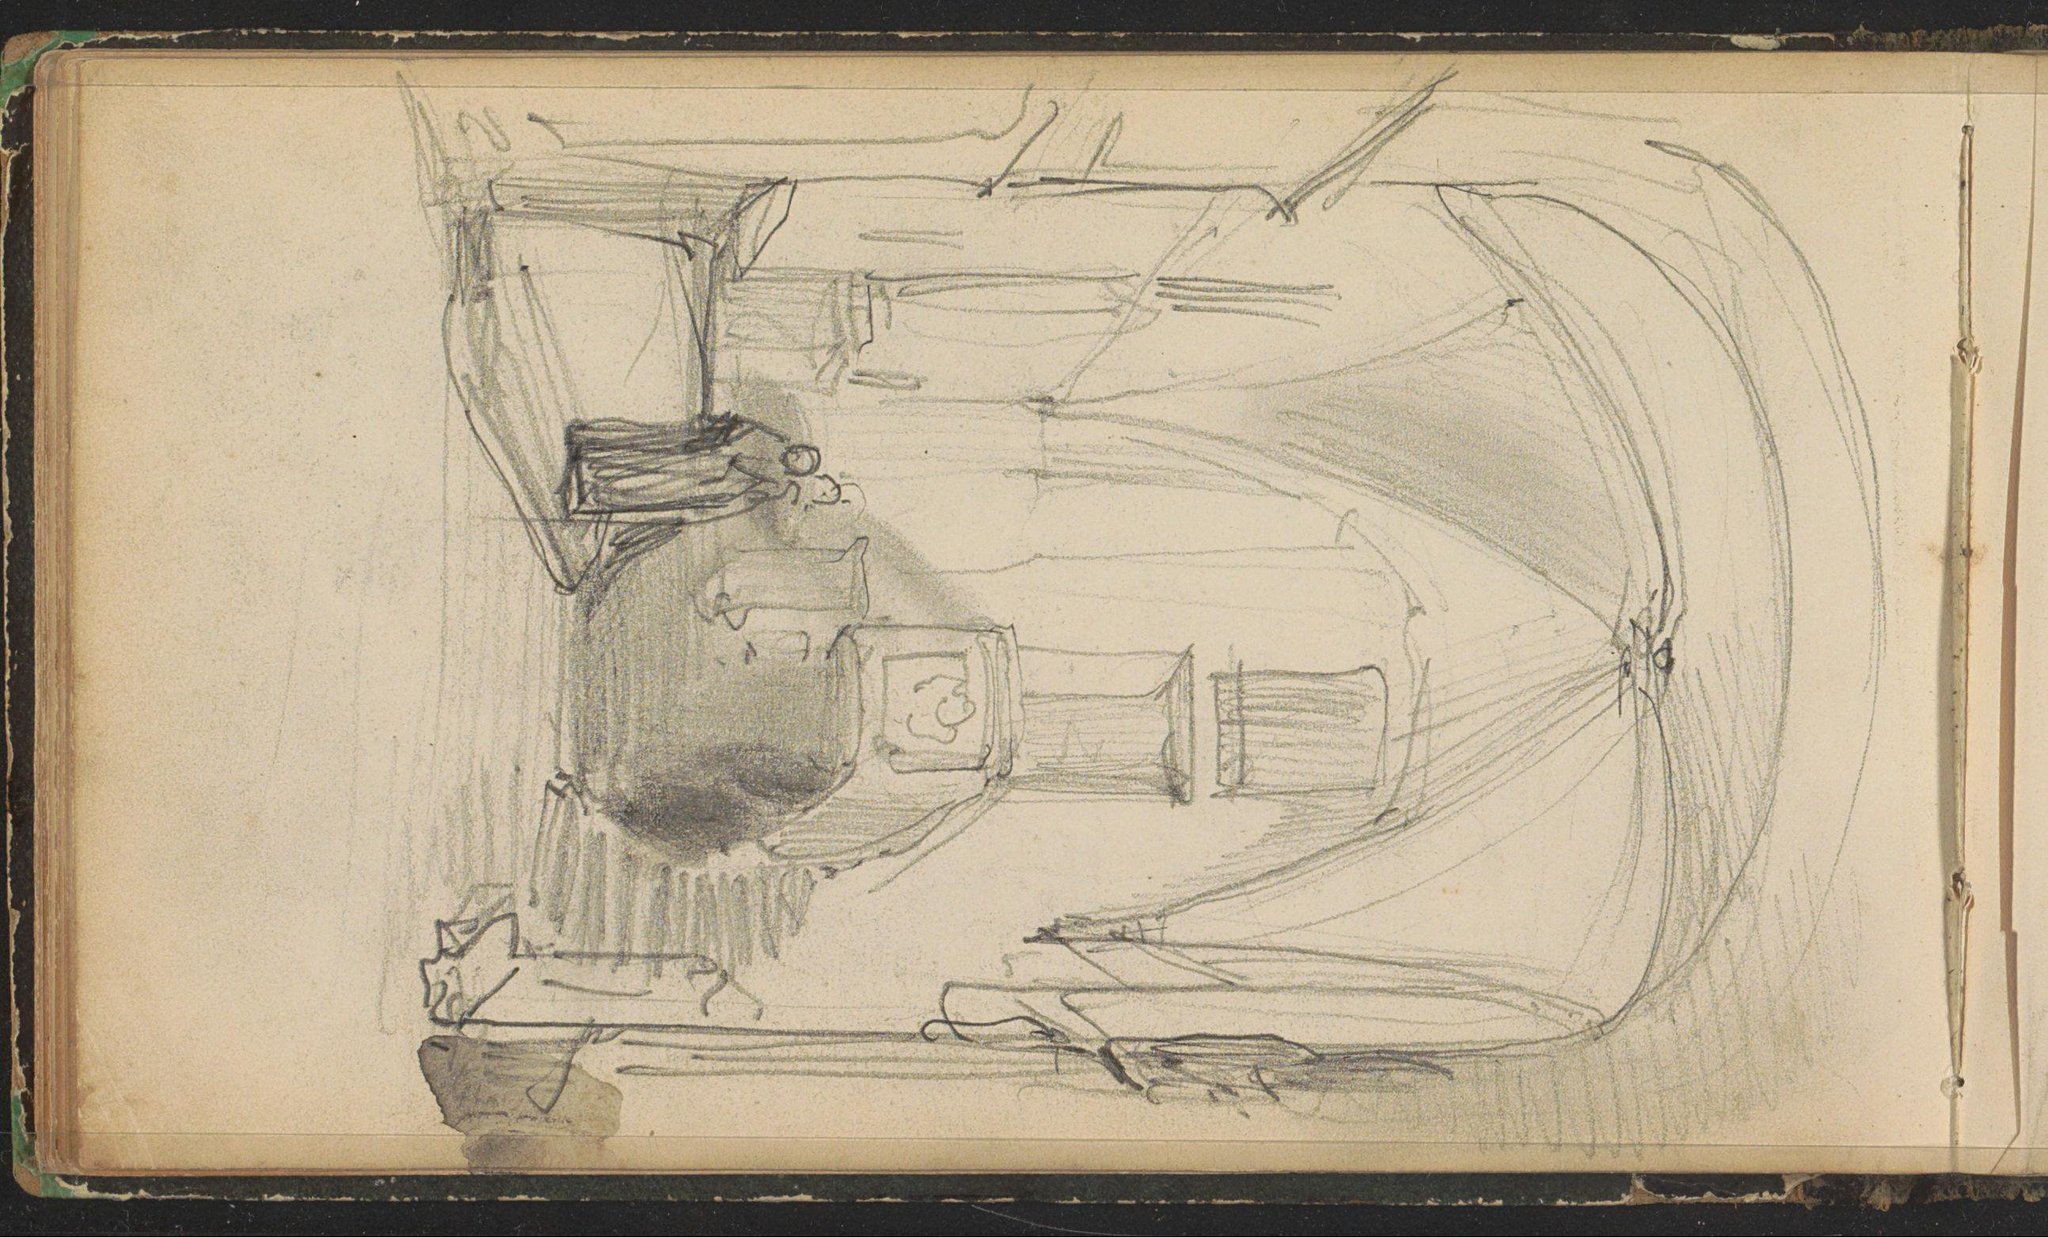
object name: sketchbook leaf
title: Figuur voor een kansel in een kerk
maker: johannes bosboom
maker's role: draughtsman, painter, print maker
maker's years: 1817-1891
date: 1845-1891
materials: paper, pencil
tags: standing figure, parts of church interior, pulpit, ambo, chancel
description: Blad 34 verso uit een schetsboek met 46 bladen.